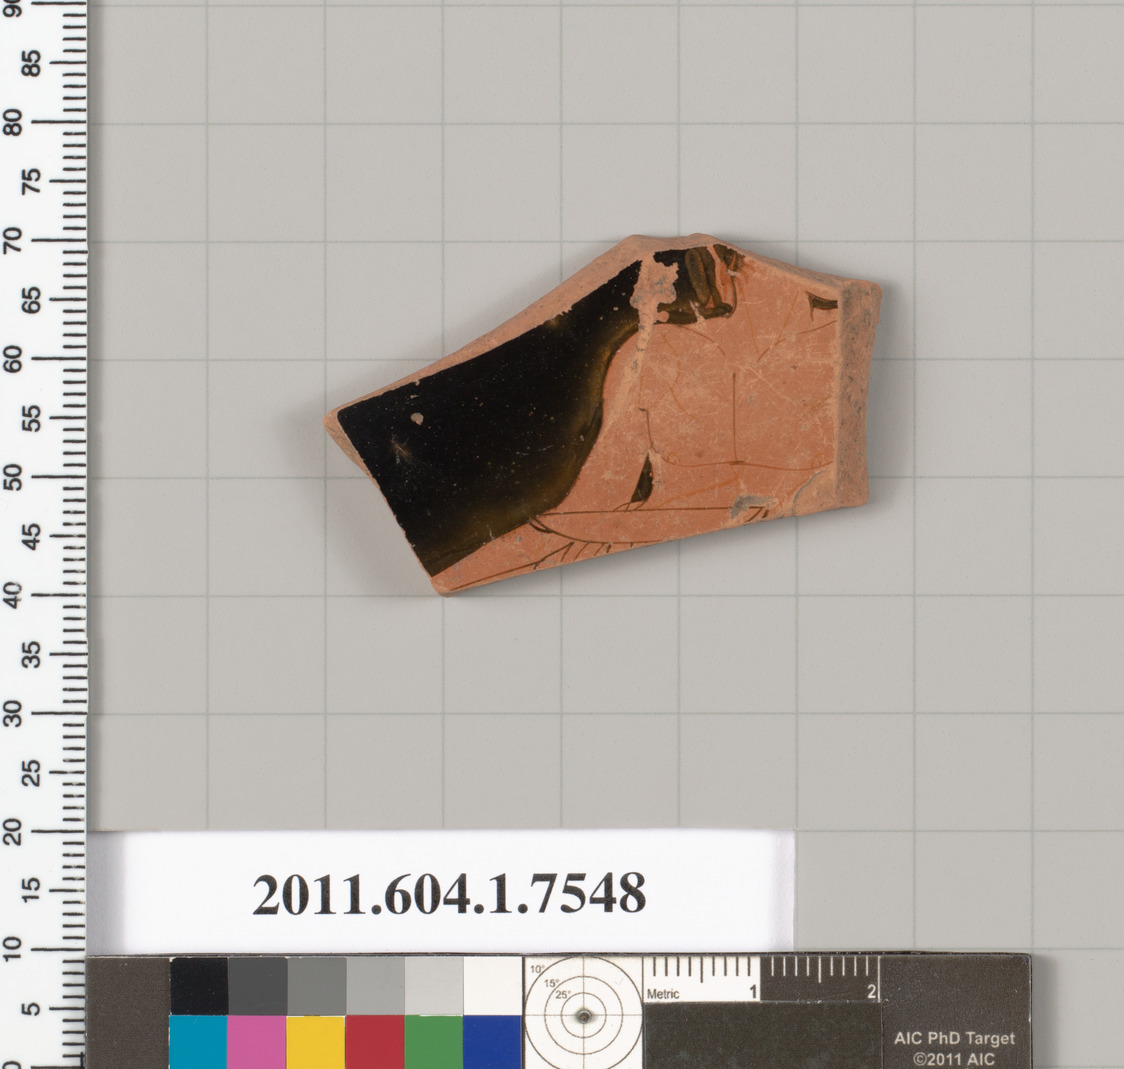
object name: kylix fragment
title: Terracotta fragment of a kylix (drinking cup)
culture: greek, attic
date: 460-450 BCE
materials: terracotta